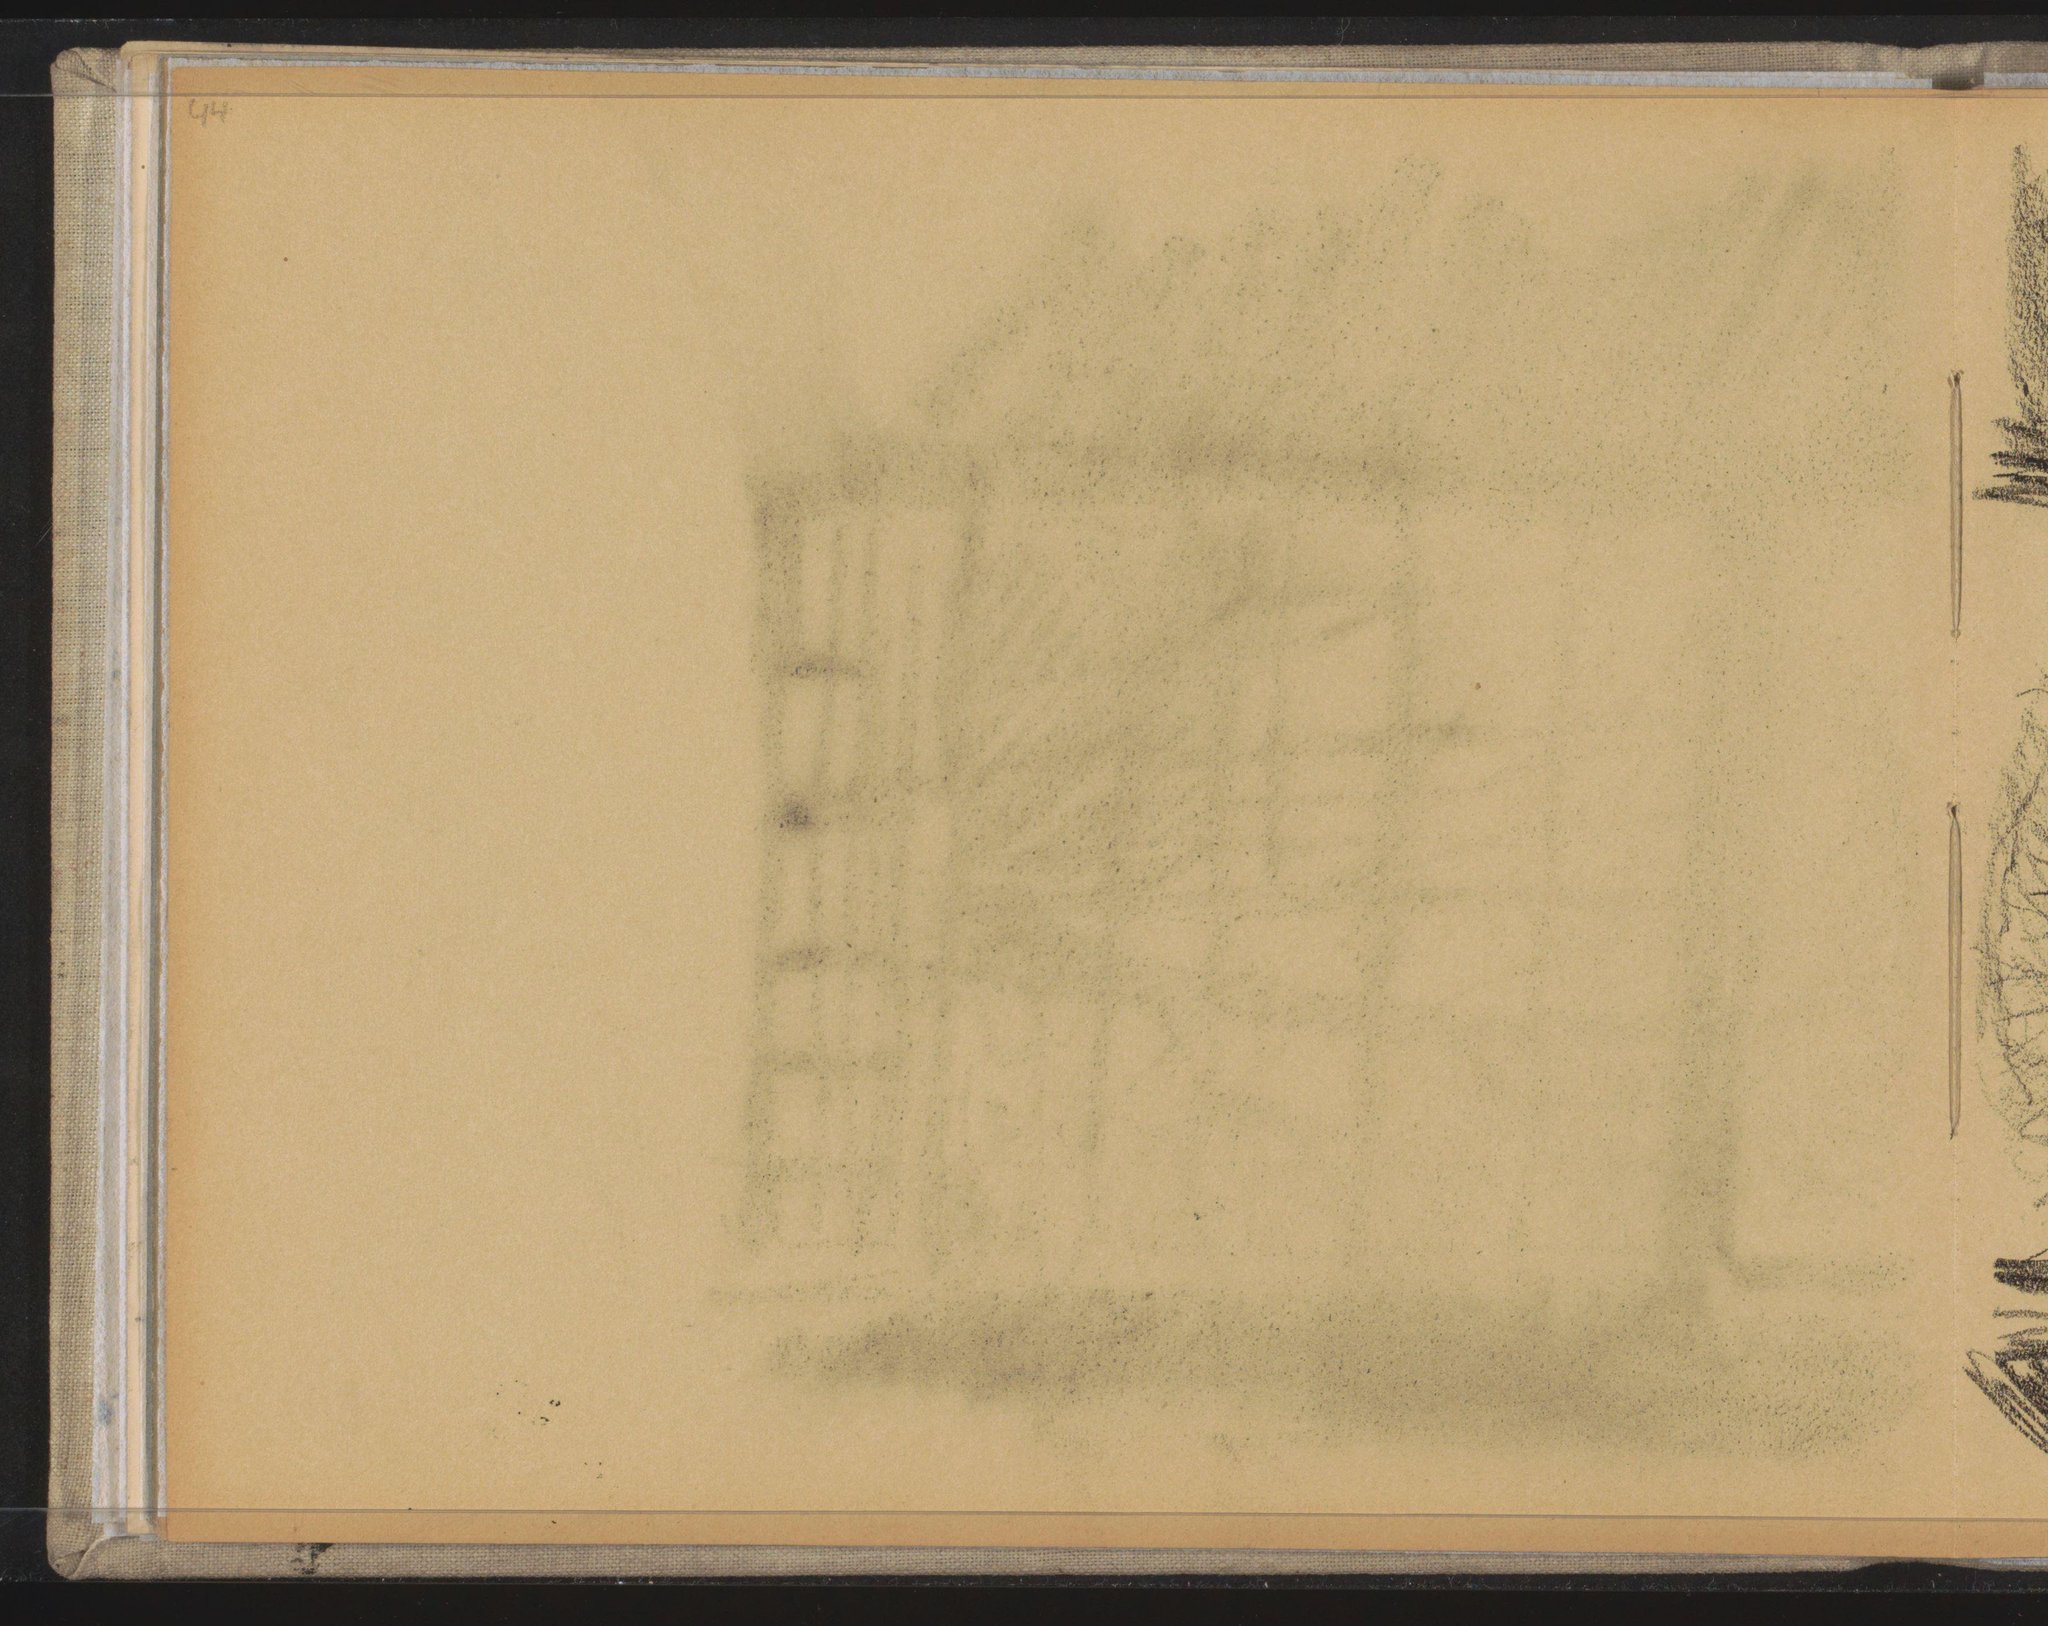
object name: sketchbook leaf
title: Abklatsch van de krijttekening op pagina 45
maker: willem witsen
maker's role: draughtsman, painter, print maker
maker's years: 1860-1923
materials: paper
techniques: printmaking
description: Pagina 44 uit een schetsboek met 43 bladen.